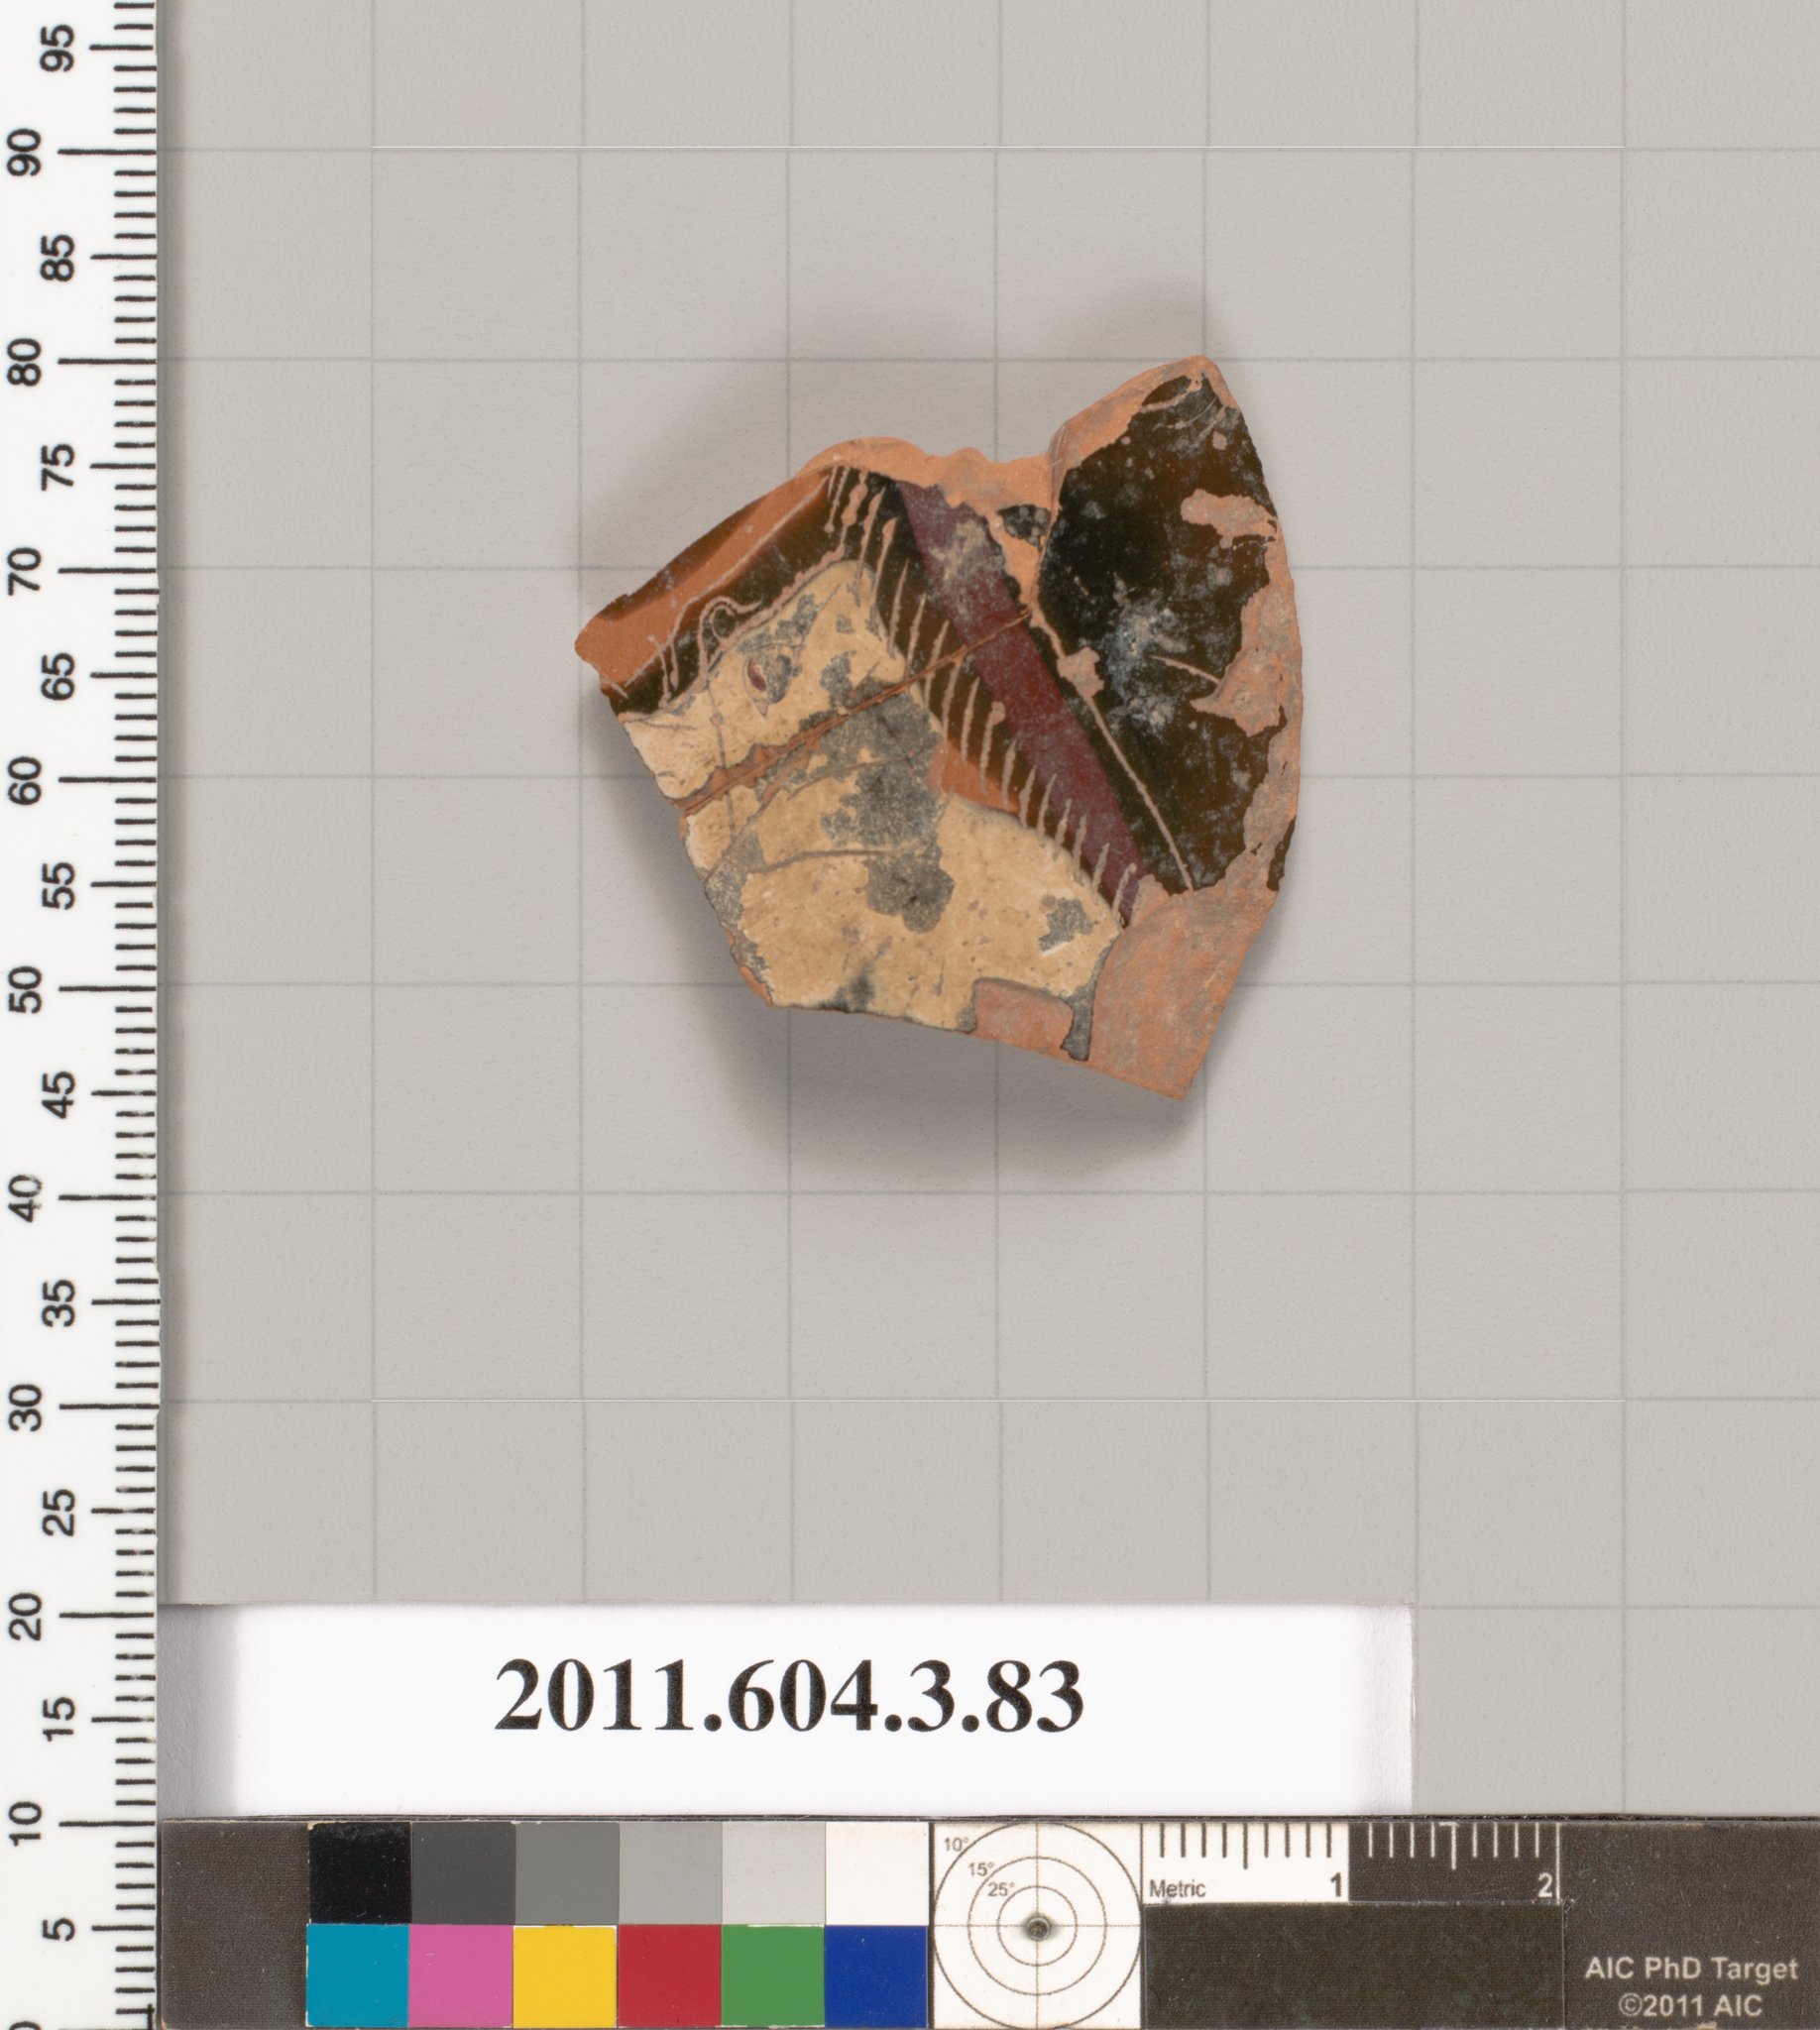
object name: amphora fragment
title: Terracotta fragment of an amphora (jar)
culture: greek, attic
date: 530-520 BCE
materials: terracotta